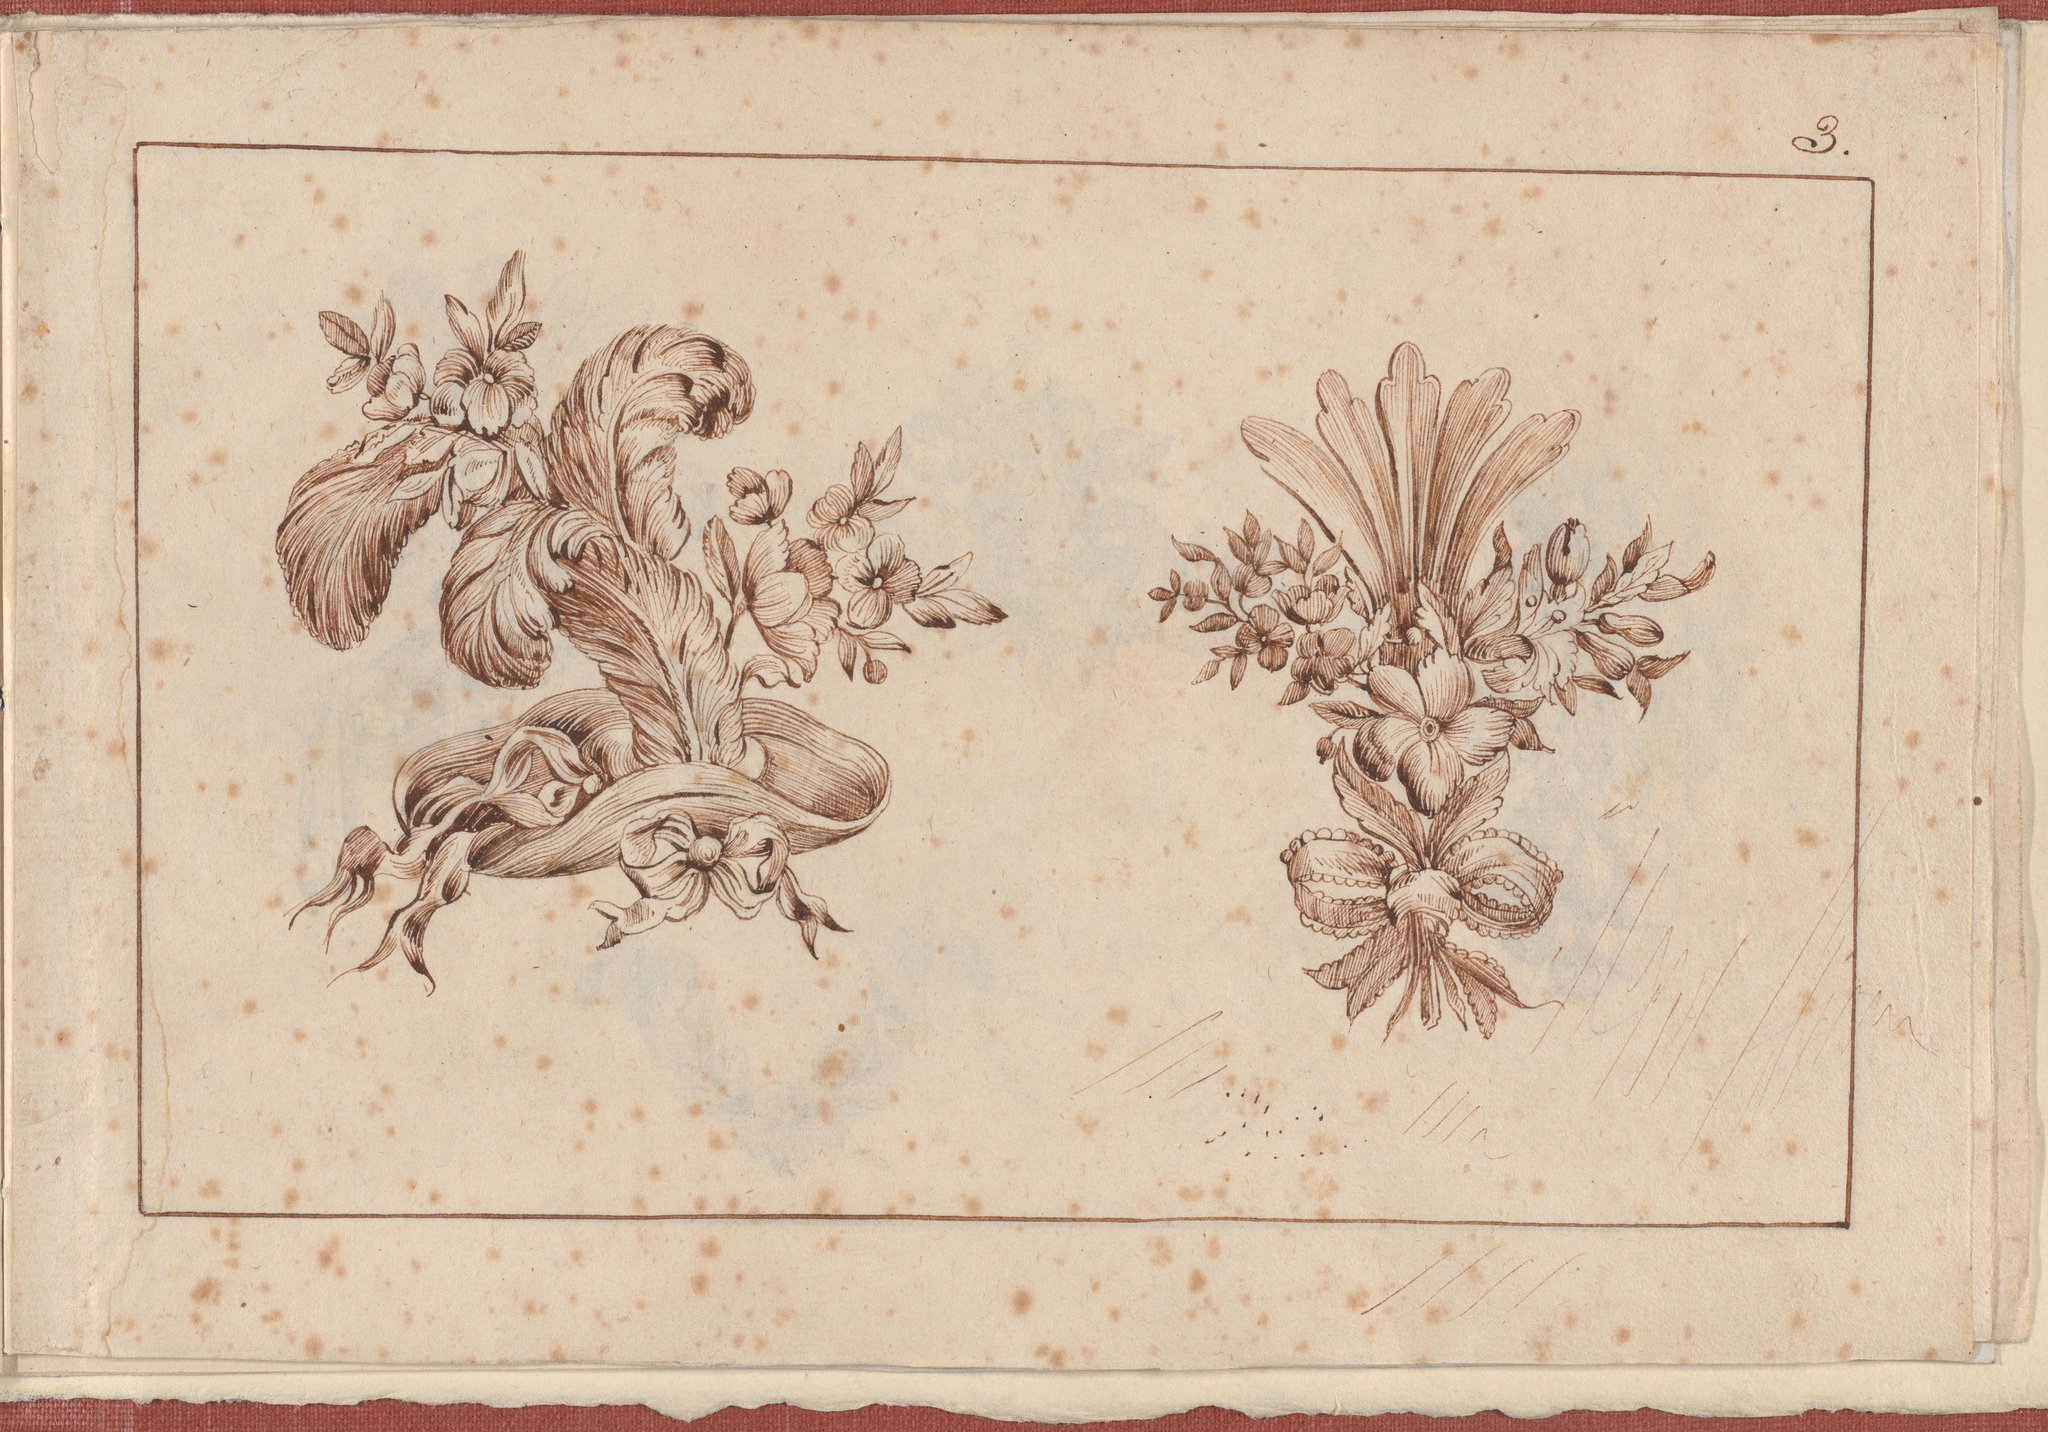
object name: album print ornament architecture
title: Joaillerie: Album of Jewelry Designs, Page 3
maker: anonymous, french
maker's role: artist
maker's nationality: french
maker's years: 1400-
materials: ink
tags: jewelry